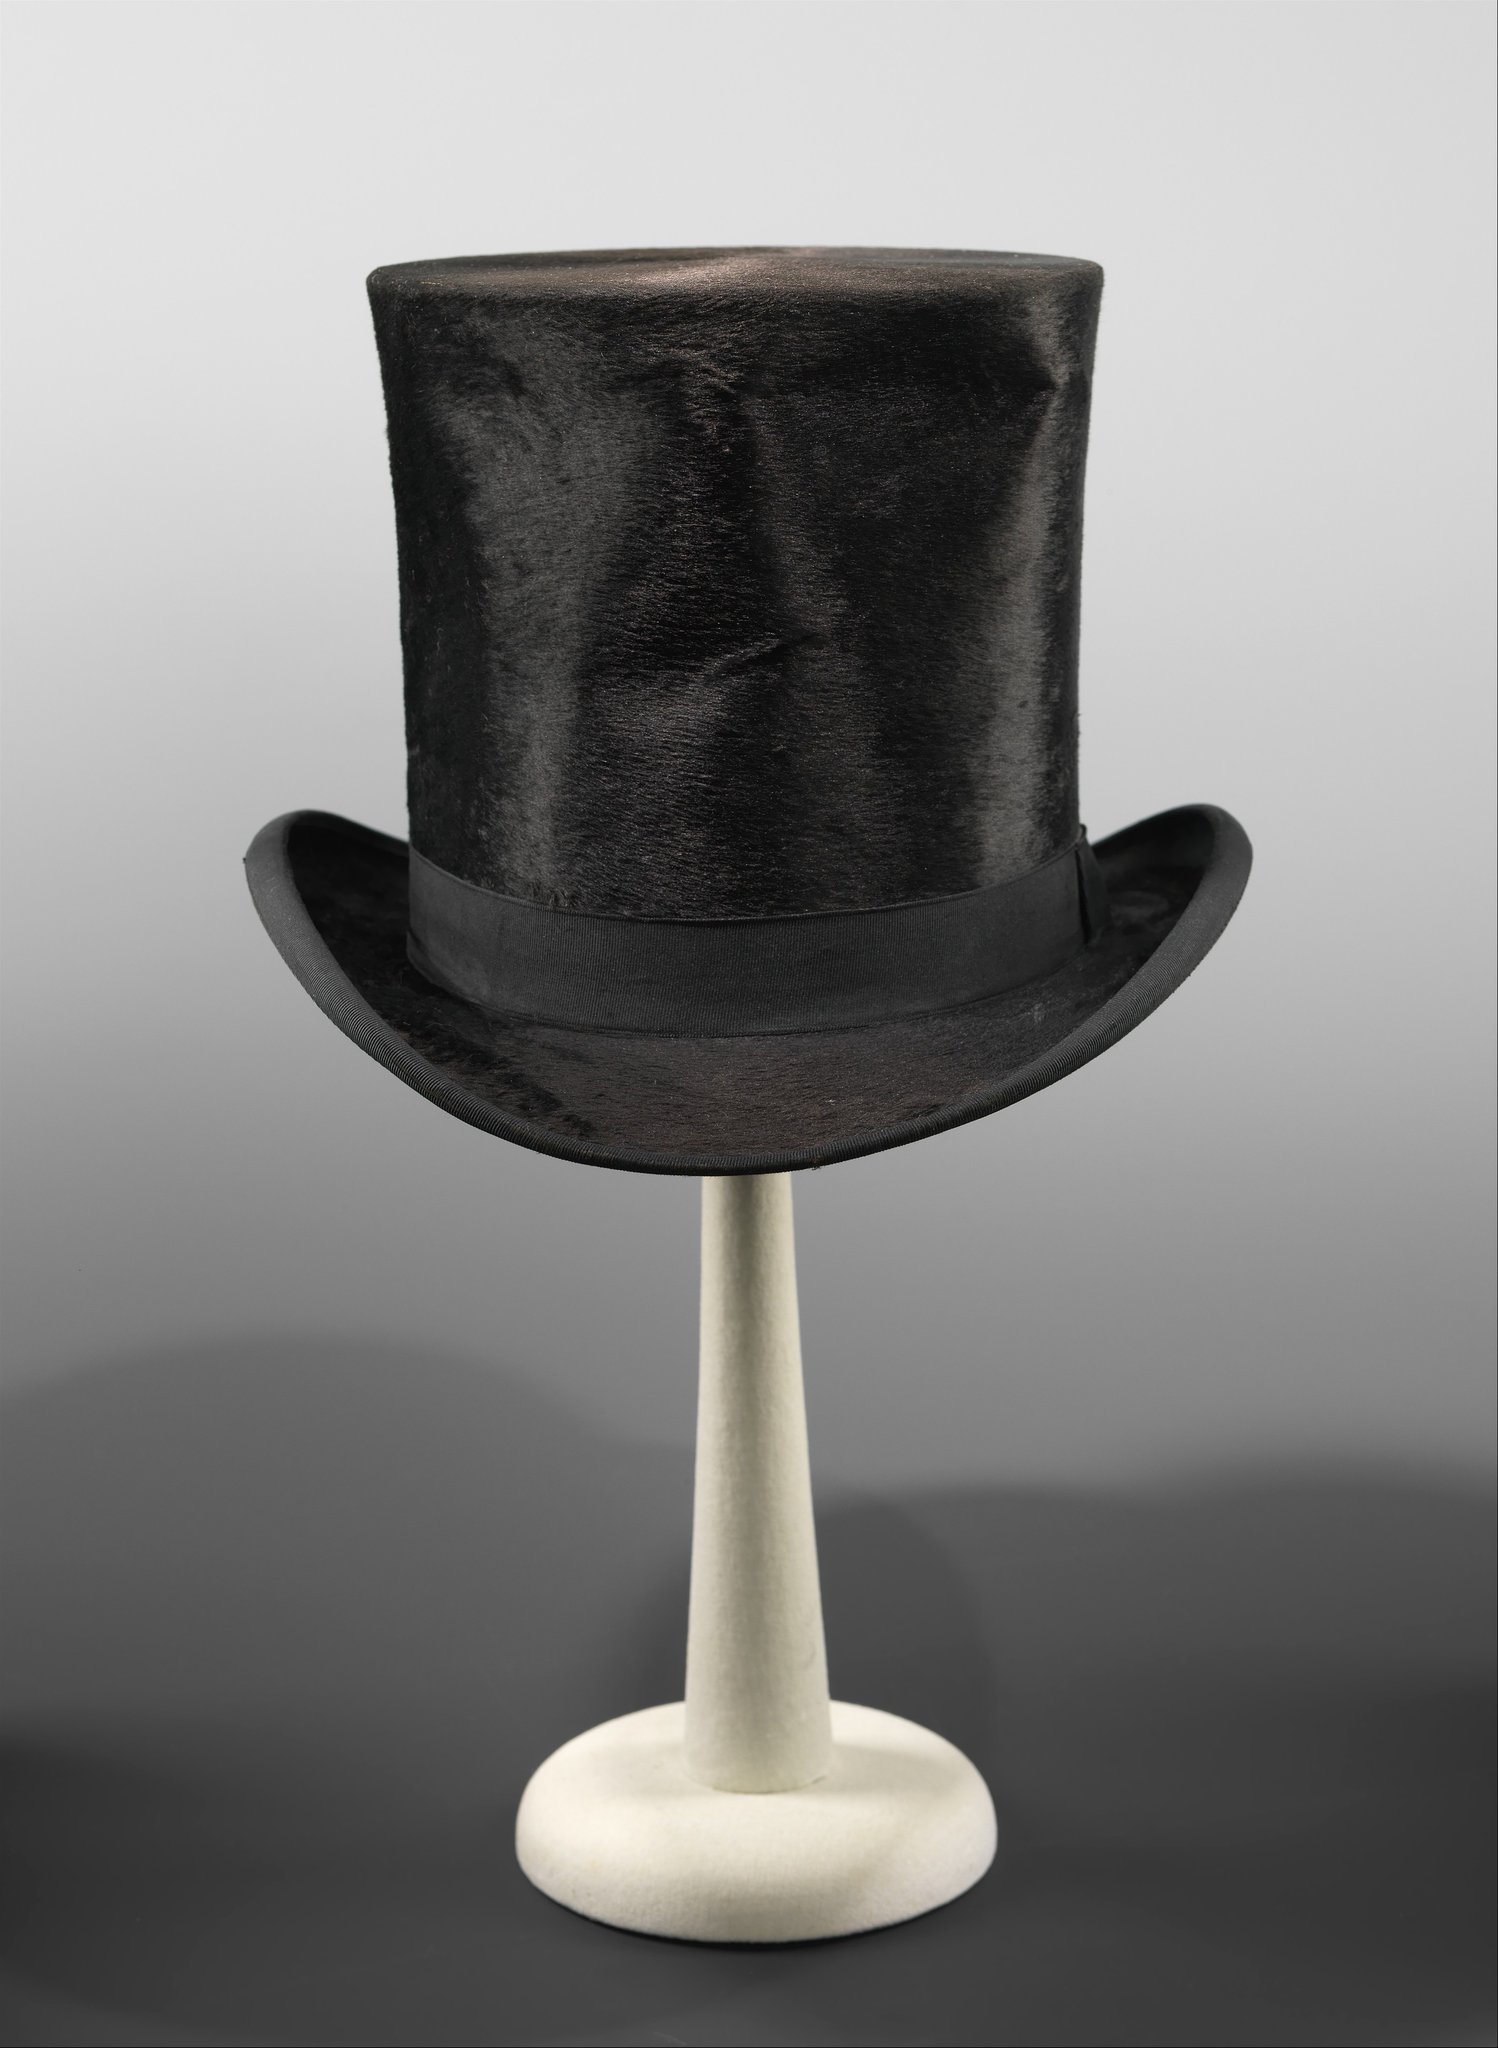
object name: top hat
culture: british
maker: melton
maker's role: designer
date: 1875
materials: silk